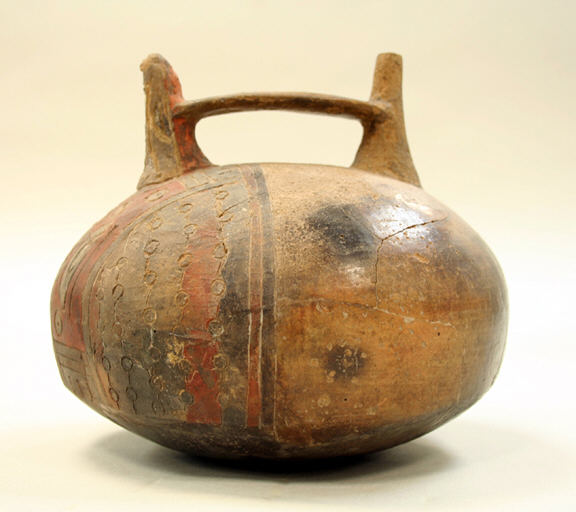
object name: bottle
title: Painted bridge and spout bottle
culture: paracas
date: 700-401 BCE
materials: ceramic, pigment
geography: peru